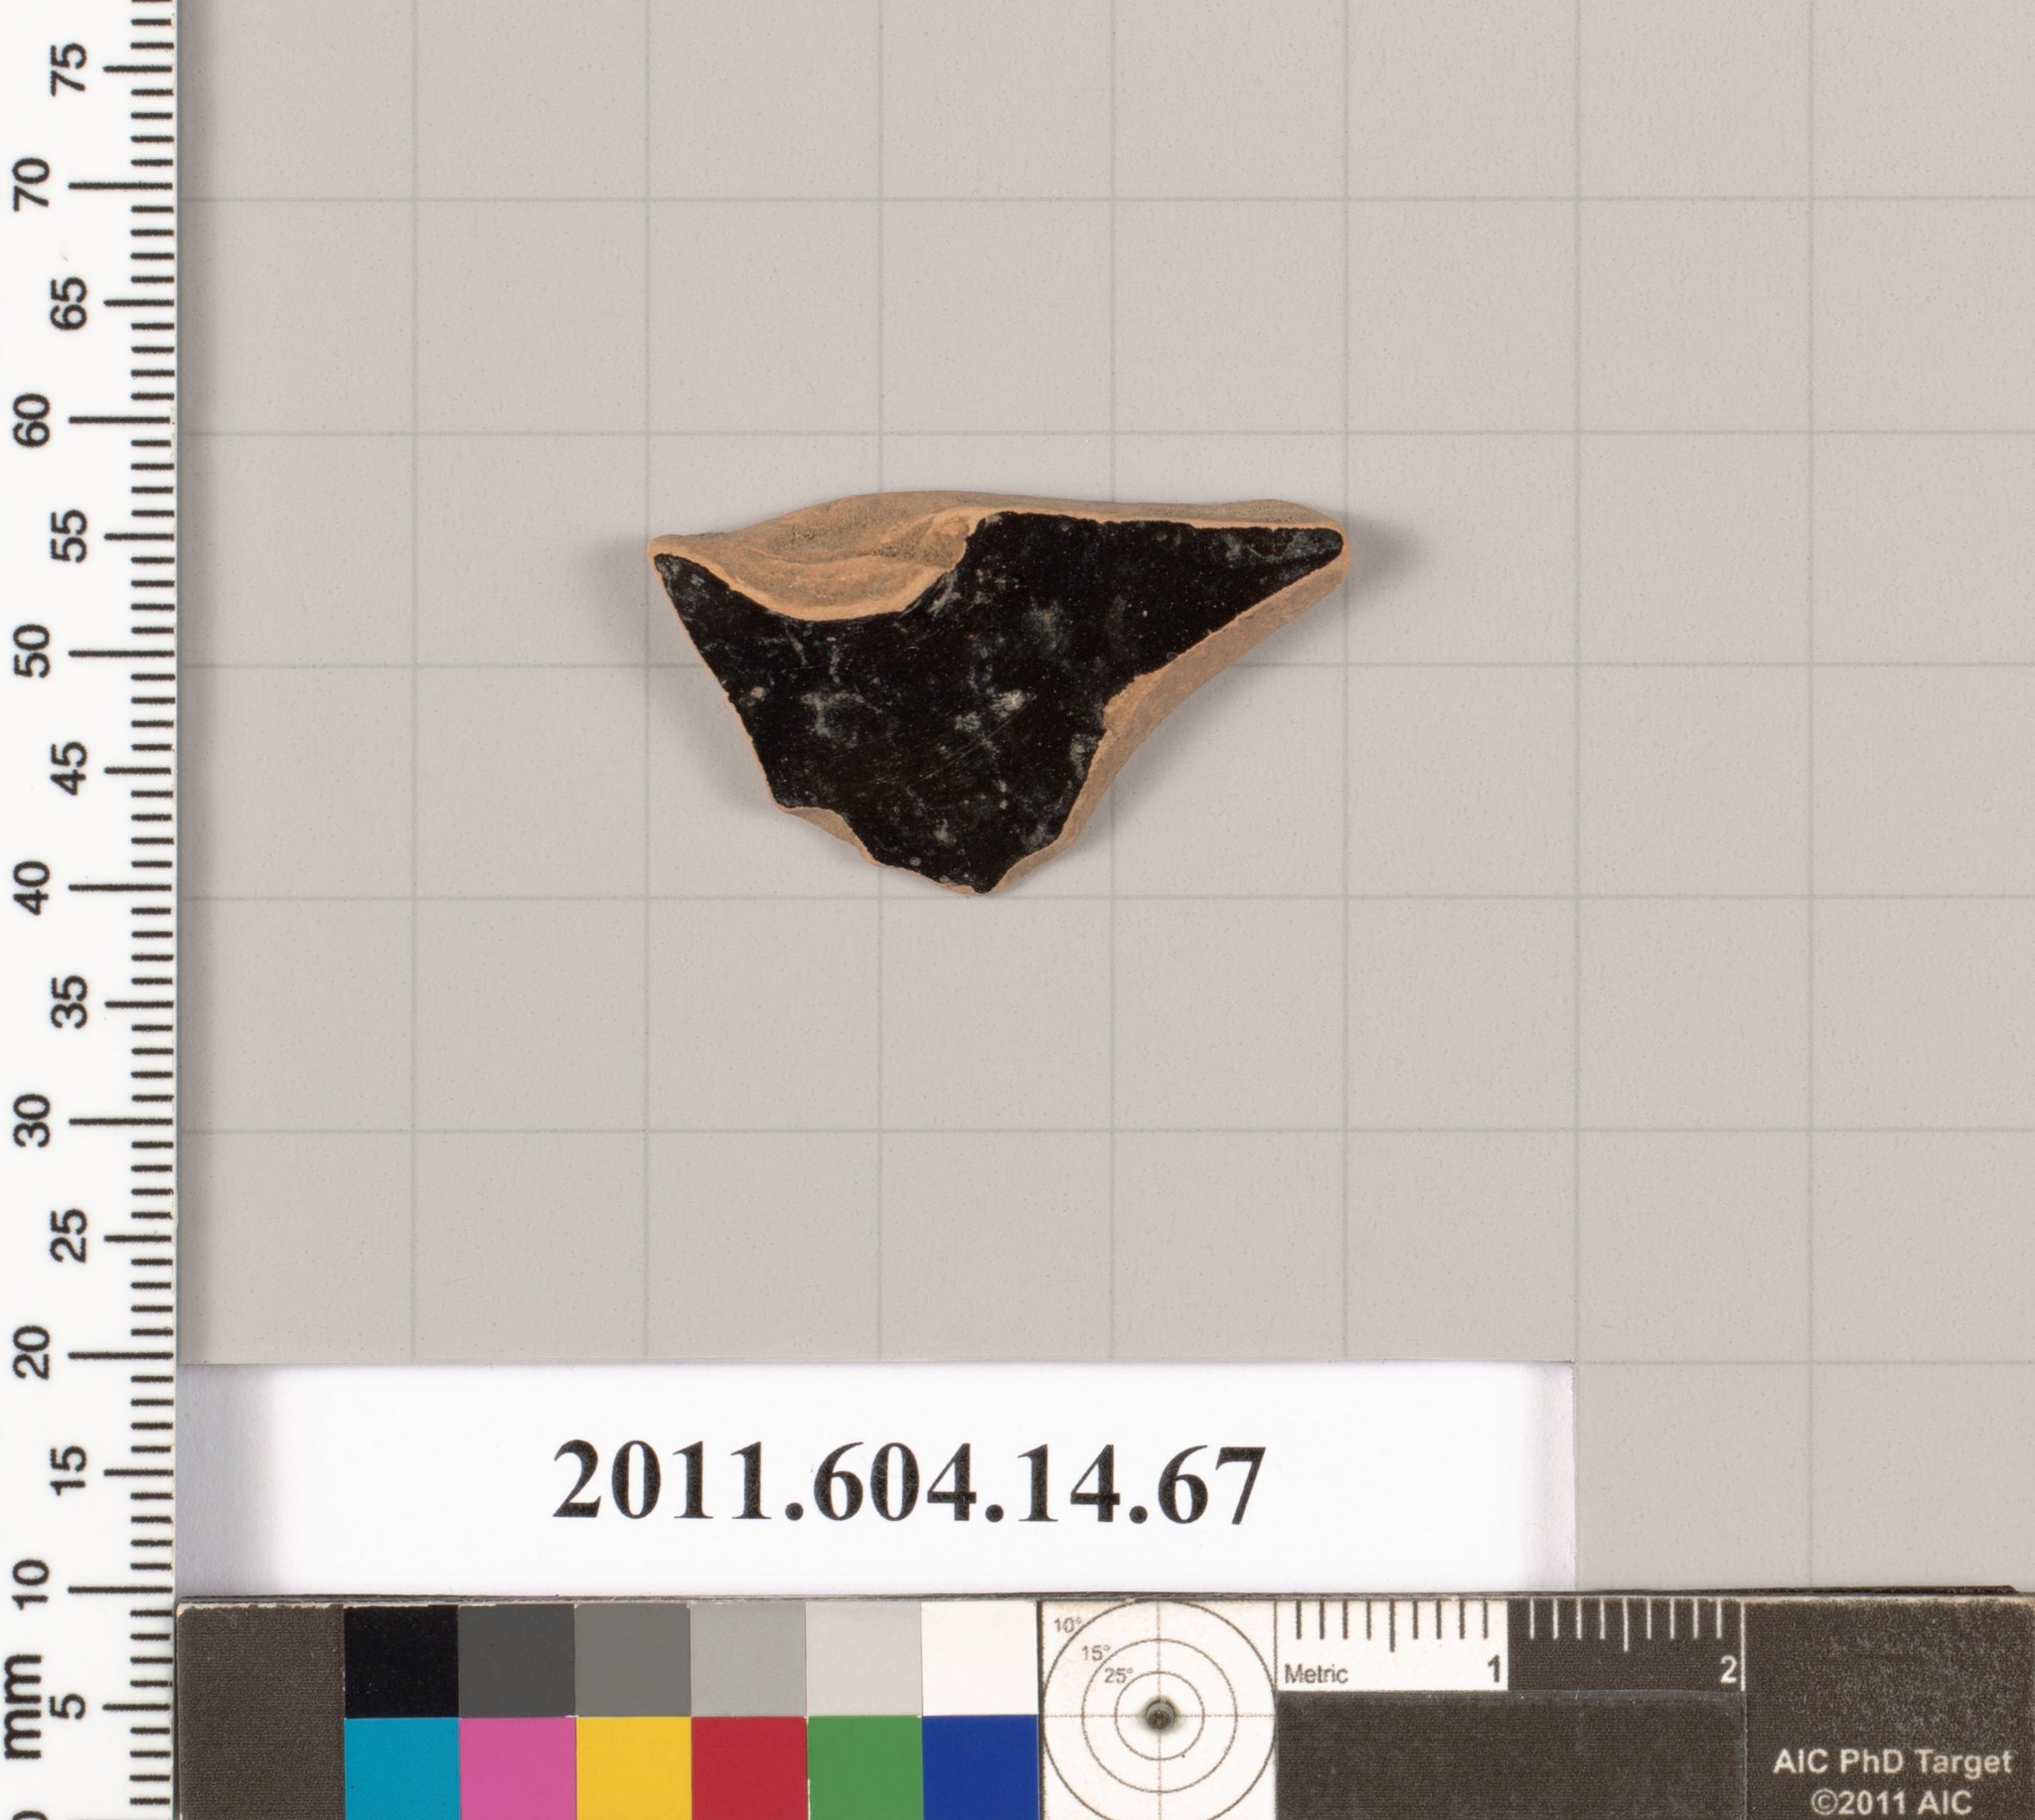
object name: kylix fragment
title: Terracotta fragment of a kylix (drinking cup)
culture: unknown fabric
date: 600-401 BCE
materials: terracotta